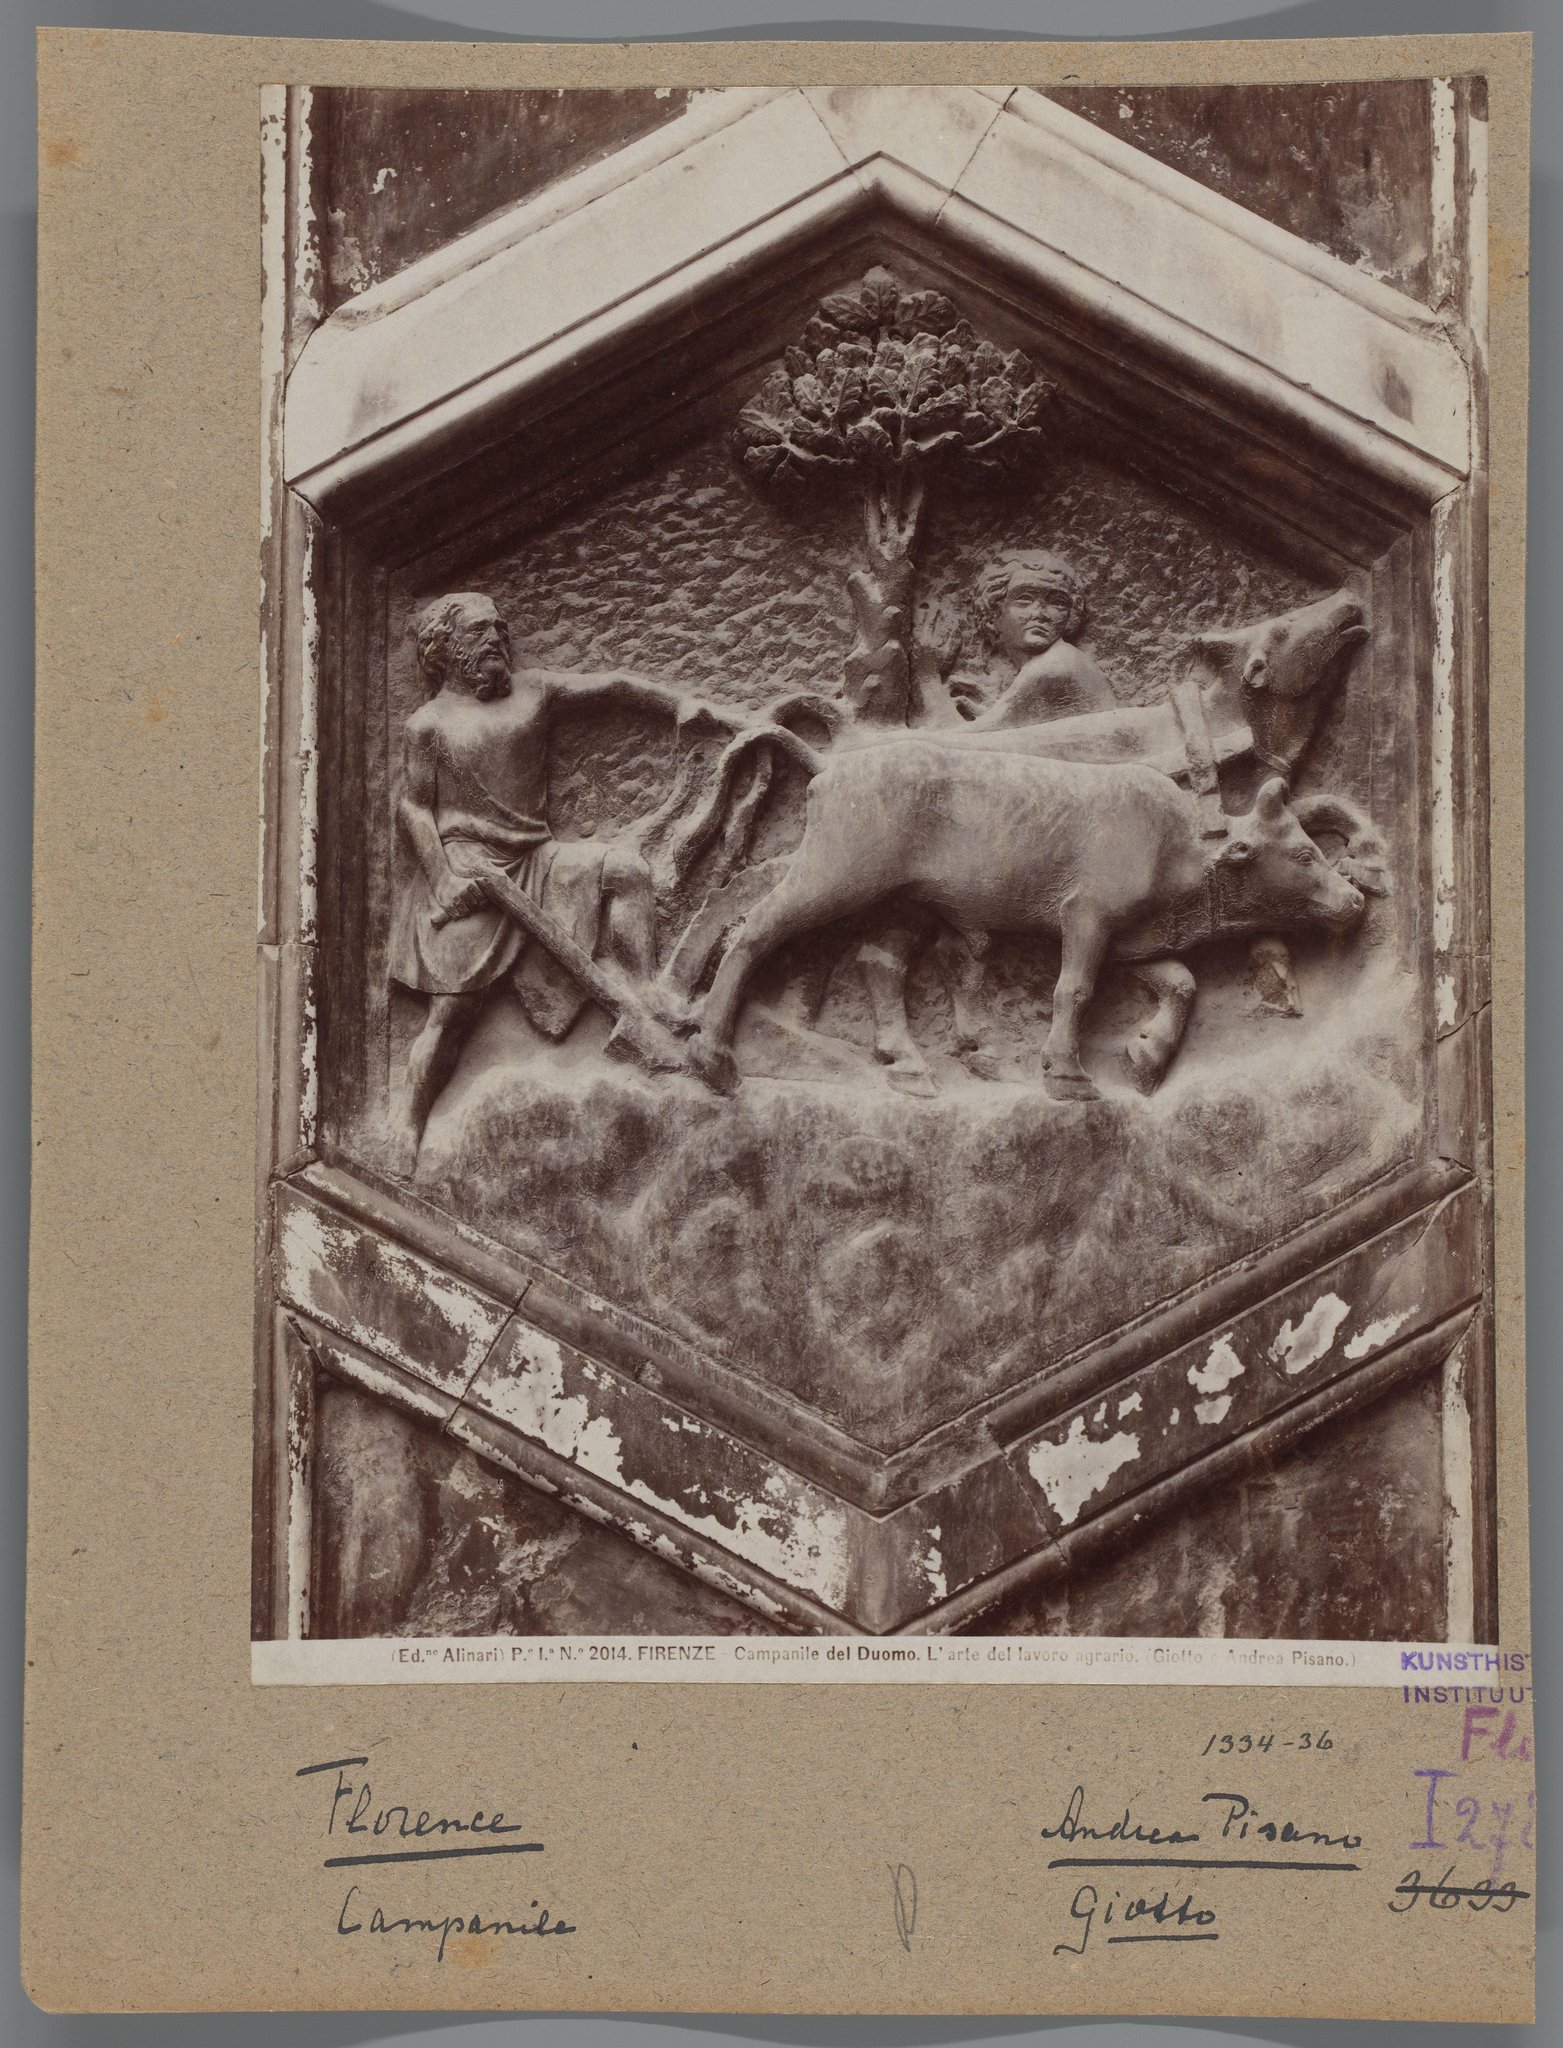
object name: photograph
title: Italië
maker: Anonymous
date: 1880-1910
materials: photographic support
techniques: albumen print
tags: italy